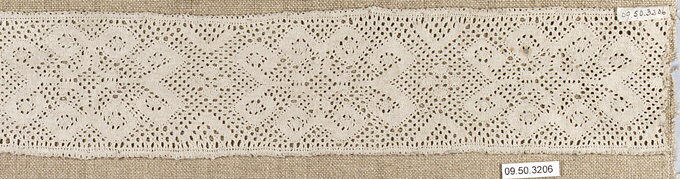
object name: strip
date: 1601-1700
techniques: lace